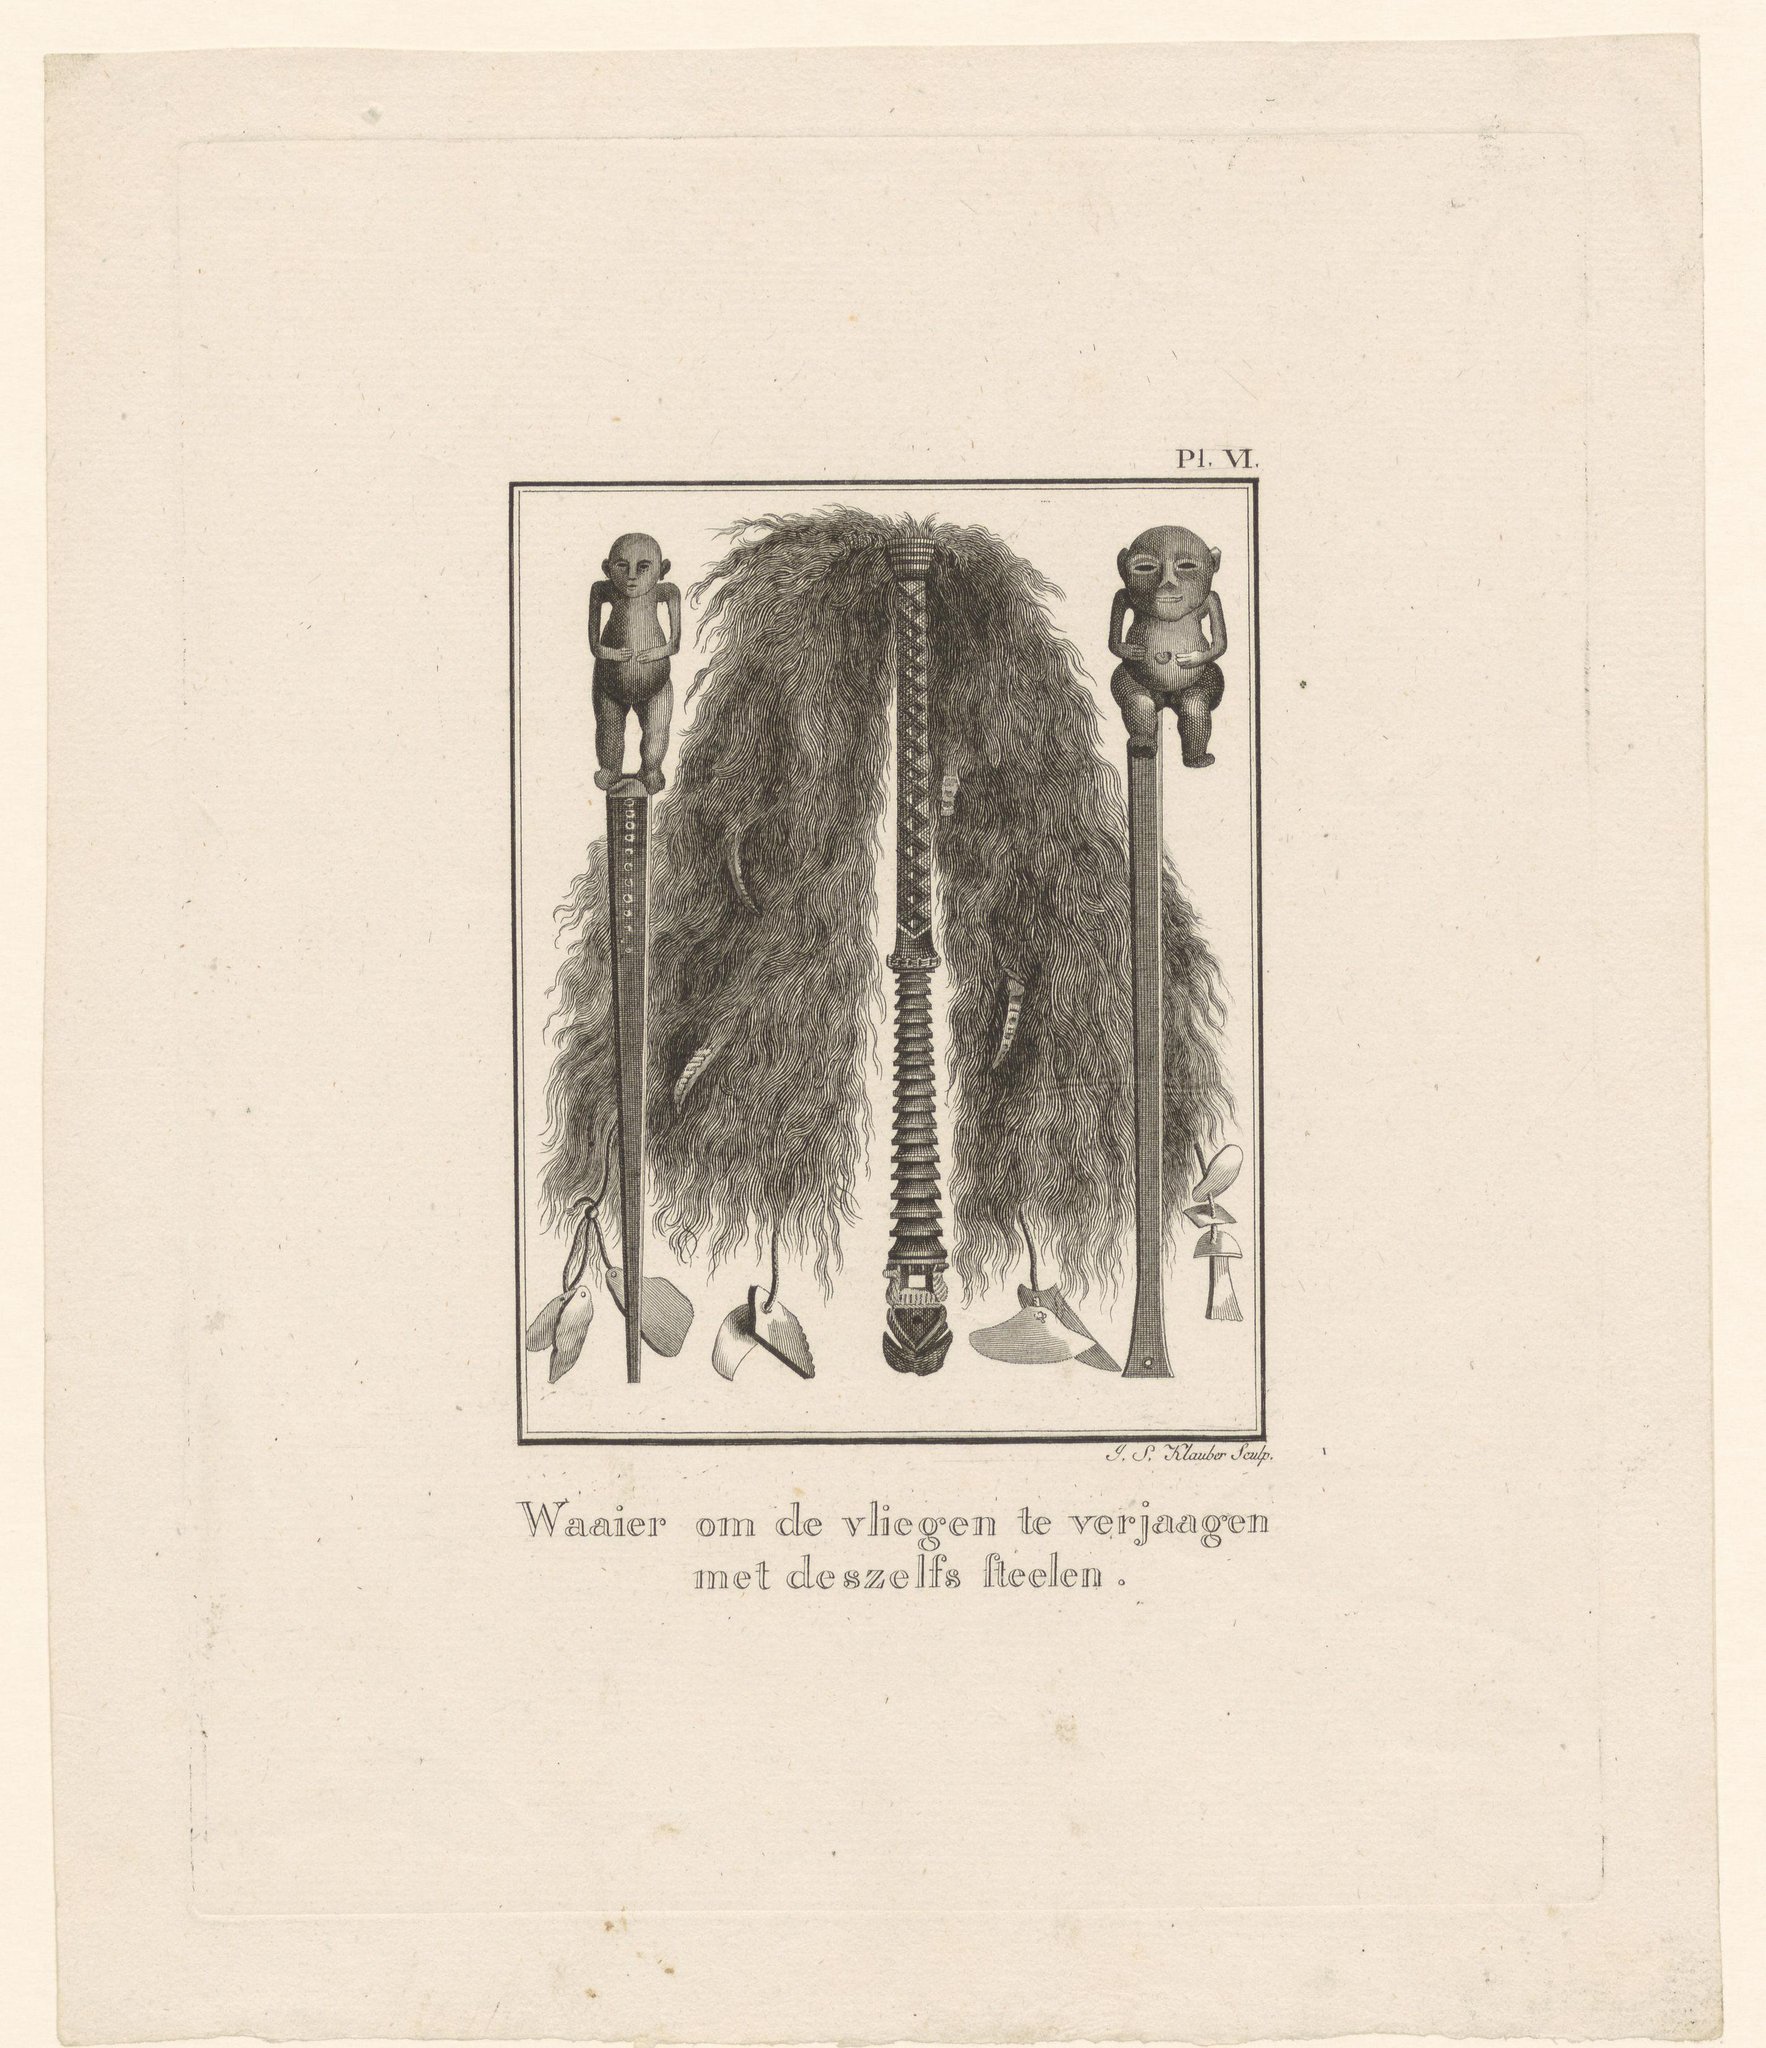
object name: print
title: Waaiers met ornamenten in houtsnijwerk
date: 1797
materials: paper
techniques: engraving, etching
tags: fan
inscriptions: number: ‘VI’, collector's mark: Lugt 2228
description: Deze prent is mogelijk gebruikt in: Cook, James. Reize rondom de Waereld (...) met kaarten en plaaten. [Vertaald uit het Engels door] Jan David Pasteur. Leiden: Honkoop, Amsterdam: Allart, Den Haag: Van Cleef, 1797, dl. 6.